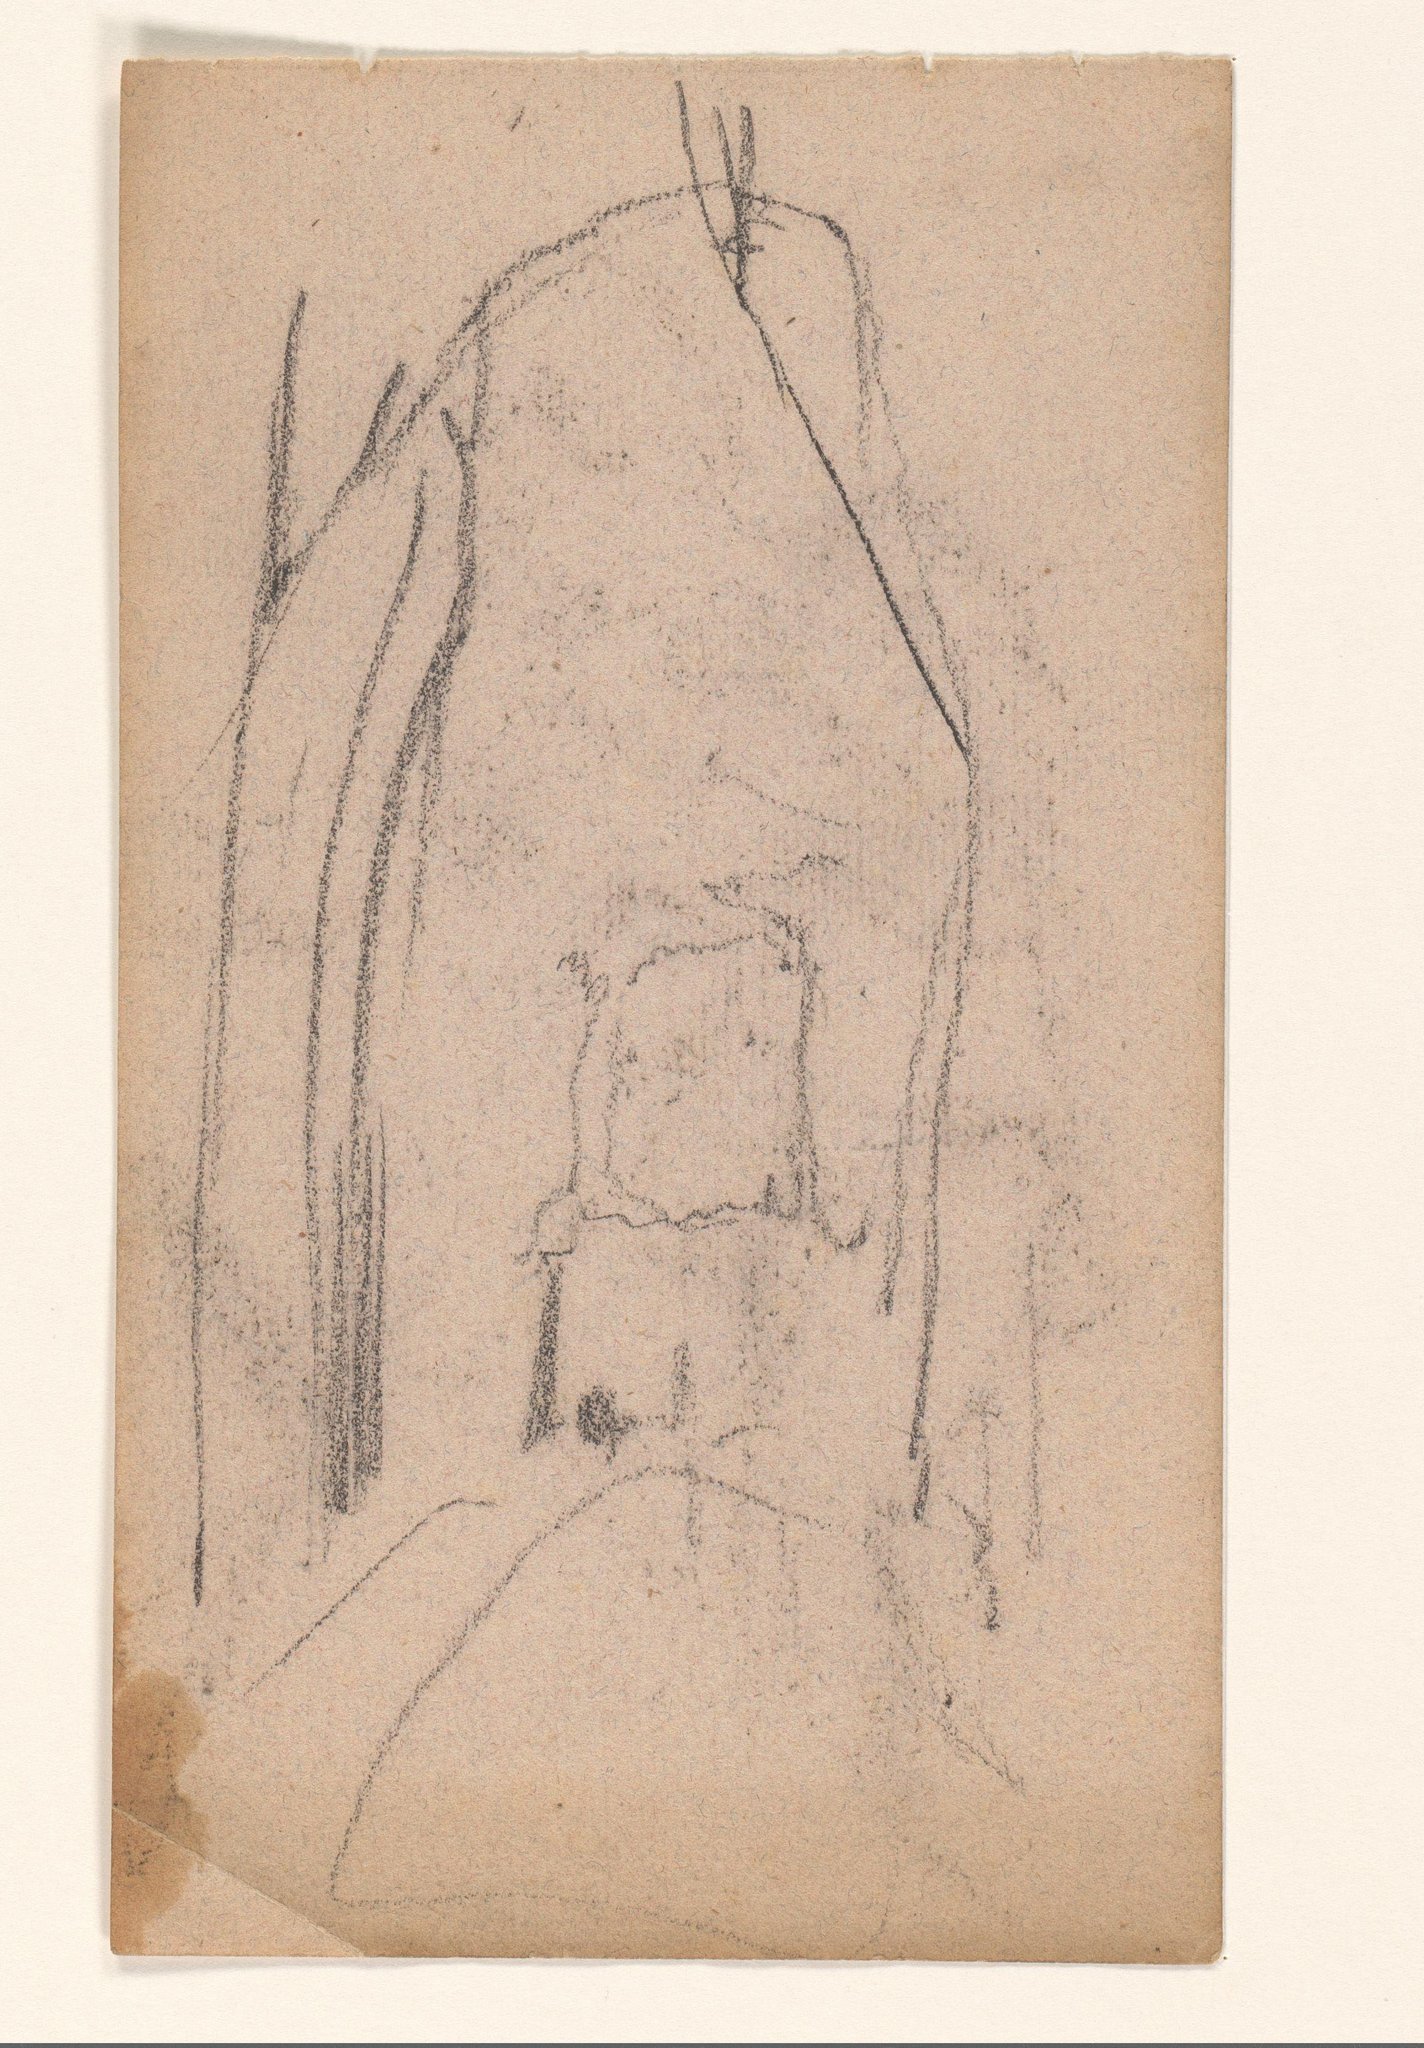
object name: drawing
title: Steeg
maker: august allebé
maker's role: draughtsman, print maker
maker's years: 1838-1927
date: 1848-1927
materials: chalk, paper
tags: lane, alley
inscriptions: collector's mark: Lugt 2228